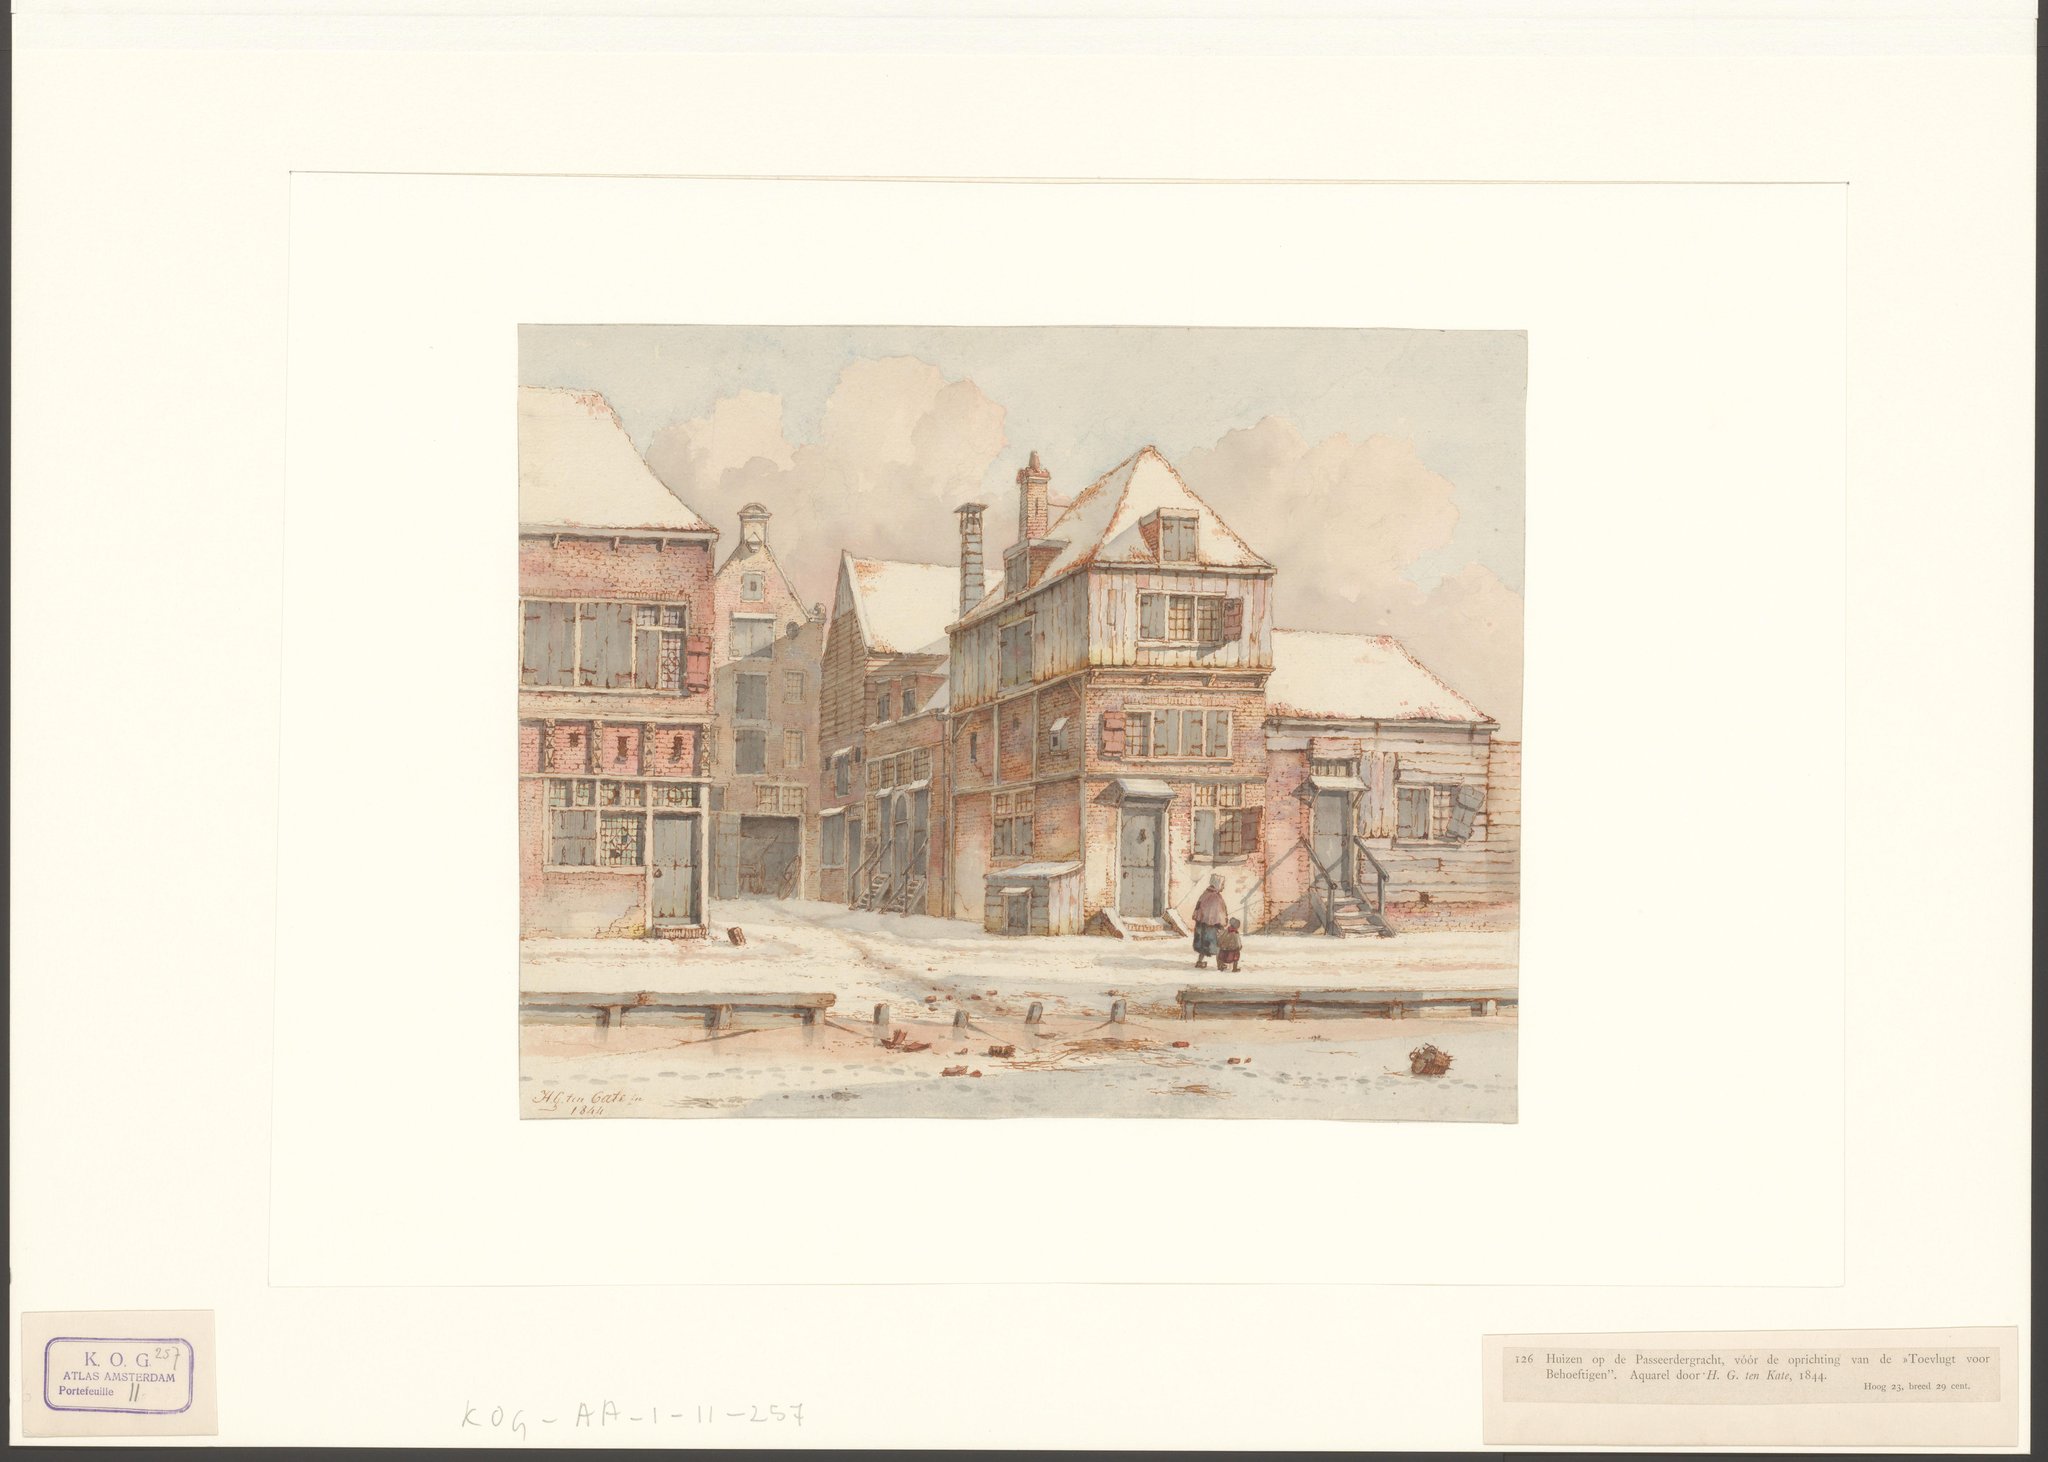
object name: drawing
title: Gezicht op enkele huizen aan de Passeerdersgracht in de winter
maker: hendrik gerrit ten cate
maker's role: draughtsman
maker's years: 1803-1856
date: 1844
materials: ink, paper, pencil, watercolor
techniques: brush, pen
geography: amsterdam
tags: city-view in general; 'veduta', canal, winter landscape; landscape symbolizing winter (the four seasons of the year), the usual house or row of houses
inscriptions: signature and date: ‘H.G. ten Cate ec / 1844’, inscription: ‘126 Huizen op (...)breed 29 cent.’, inscription: ‘Port. 11. / 257’, collector's mark: Lugt 1556, collector's mark: ‘11’ Lugt 1641b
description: Onderwerpsrubriek binnen de Atlas Amsterdam: Paleisstraat, Palmgracht, Papenbrugsteeg, Passeerdersgracht, Peperstraat, Pieterspoort (St.), Pieterssteeg (St.), Plantage, Prinseneiland.